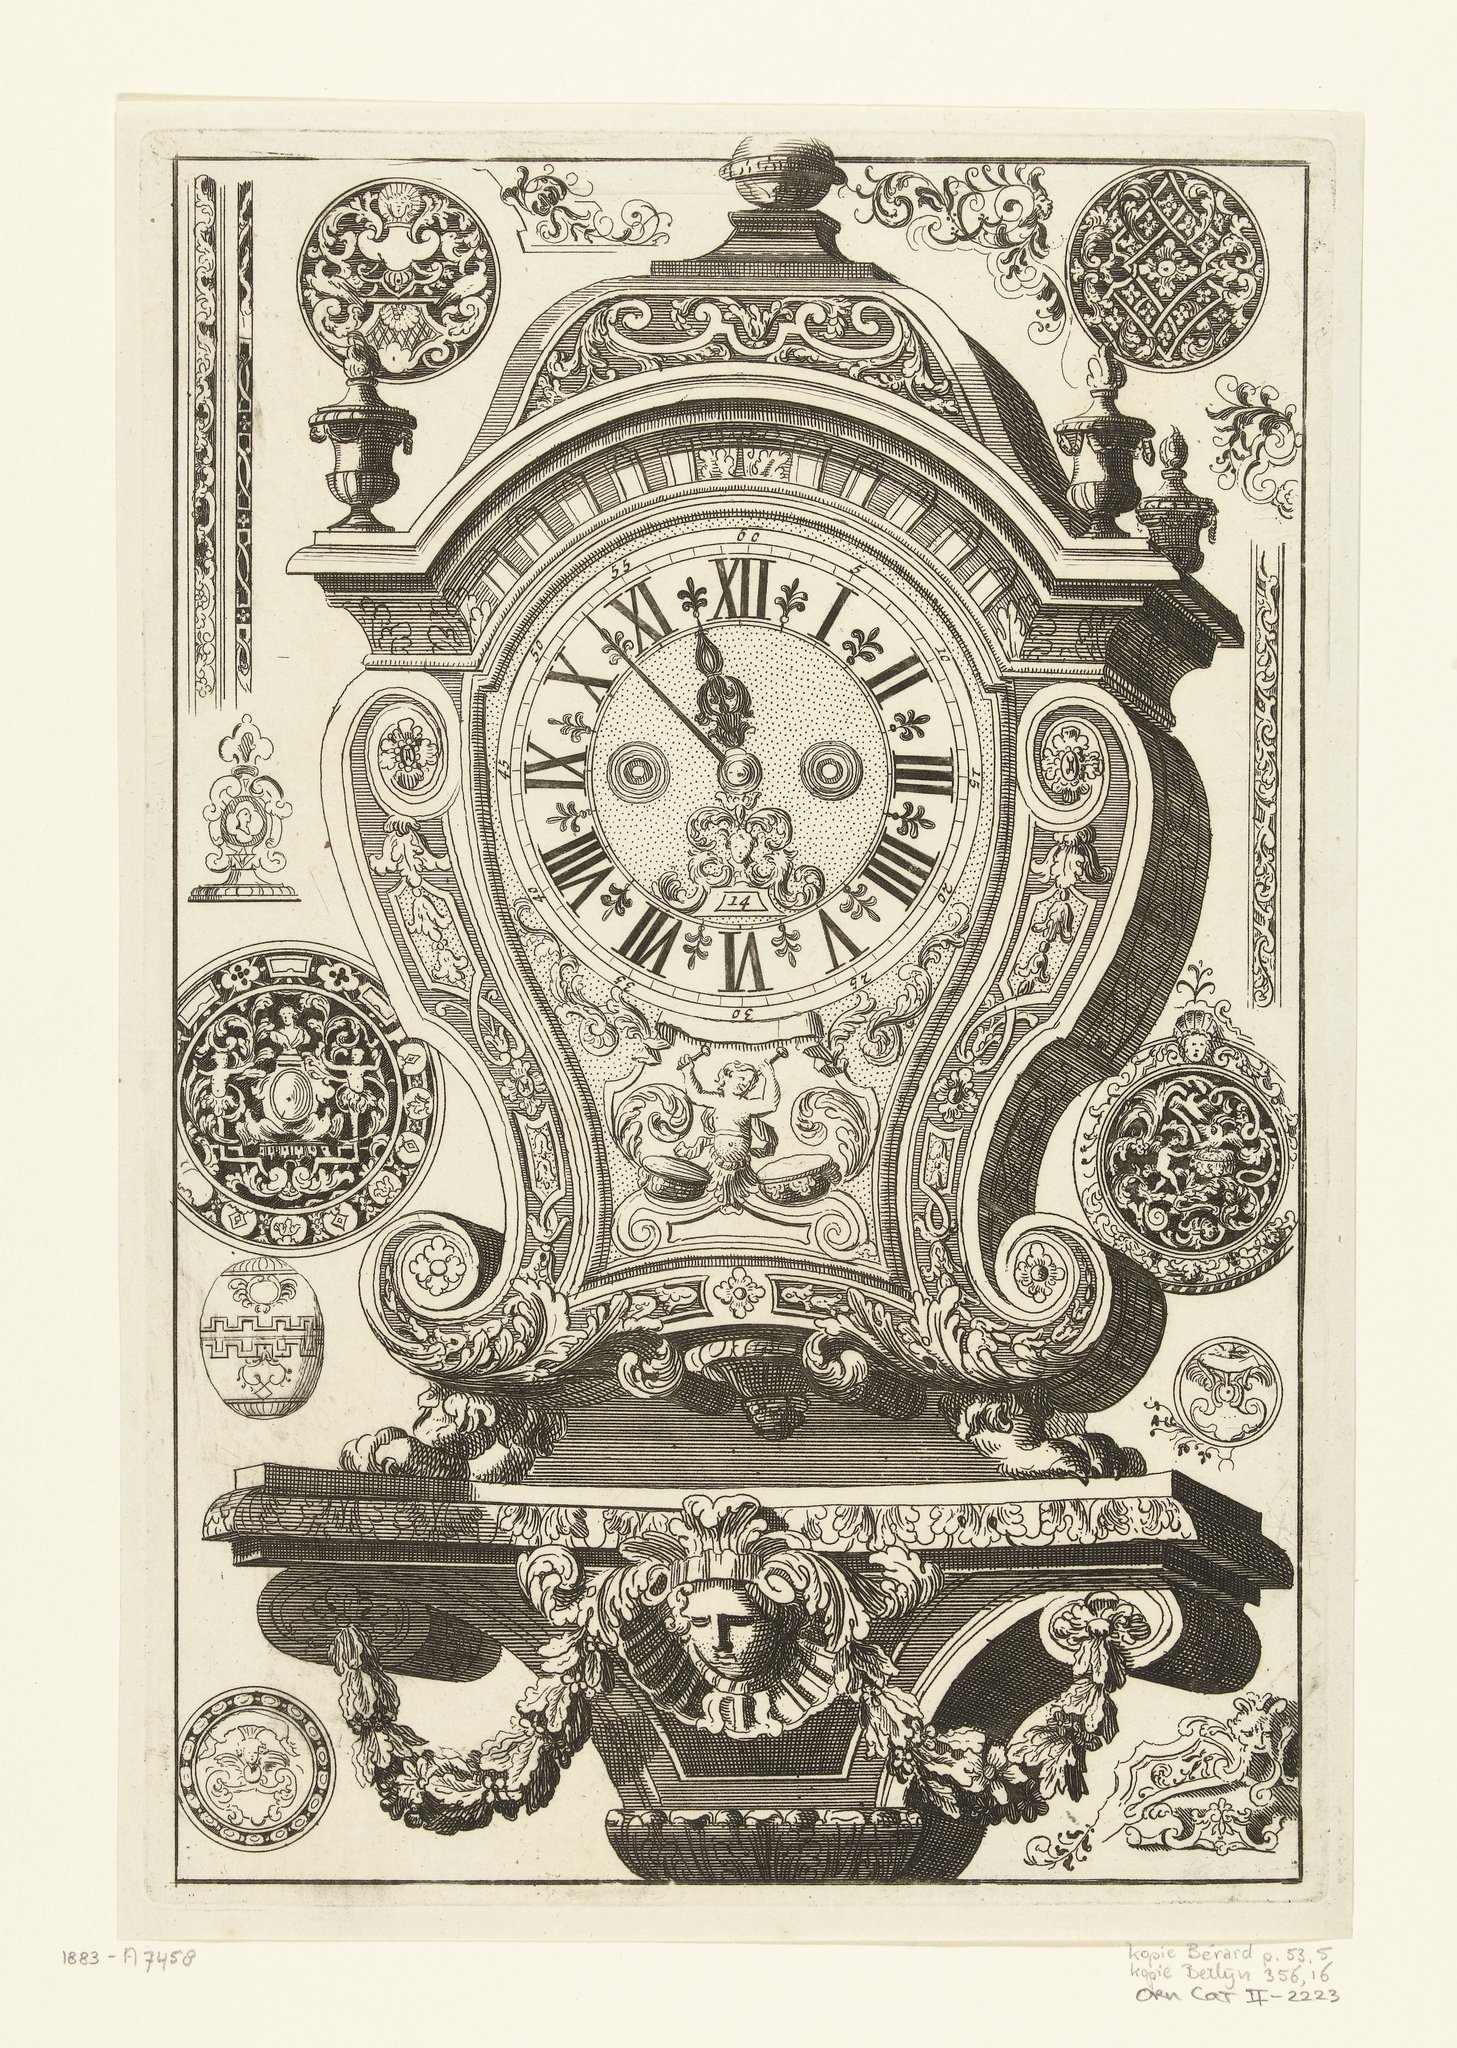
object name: print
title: Nouveaux Liure de Boites de Pendulles de Coqs et Etuys de montres et autres necessaire au Orlogeurs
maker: Anonymous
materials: paper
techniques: etching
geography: netherlands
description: Een taps toelopende pendule met een masker en guirlande aan de onderzijde. De pendule is omringd door een wijzerplaat, drie horlogekasten en elf andere ornamenten. Kopie van blad 6 uit de serie Nouveaux Liure de Boïtes de Pendulles, uitgegeven door Daniel Marot omstreeks 1706. Blad uit tweede editie.